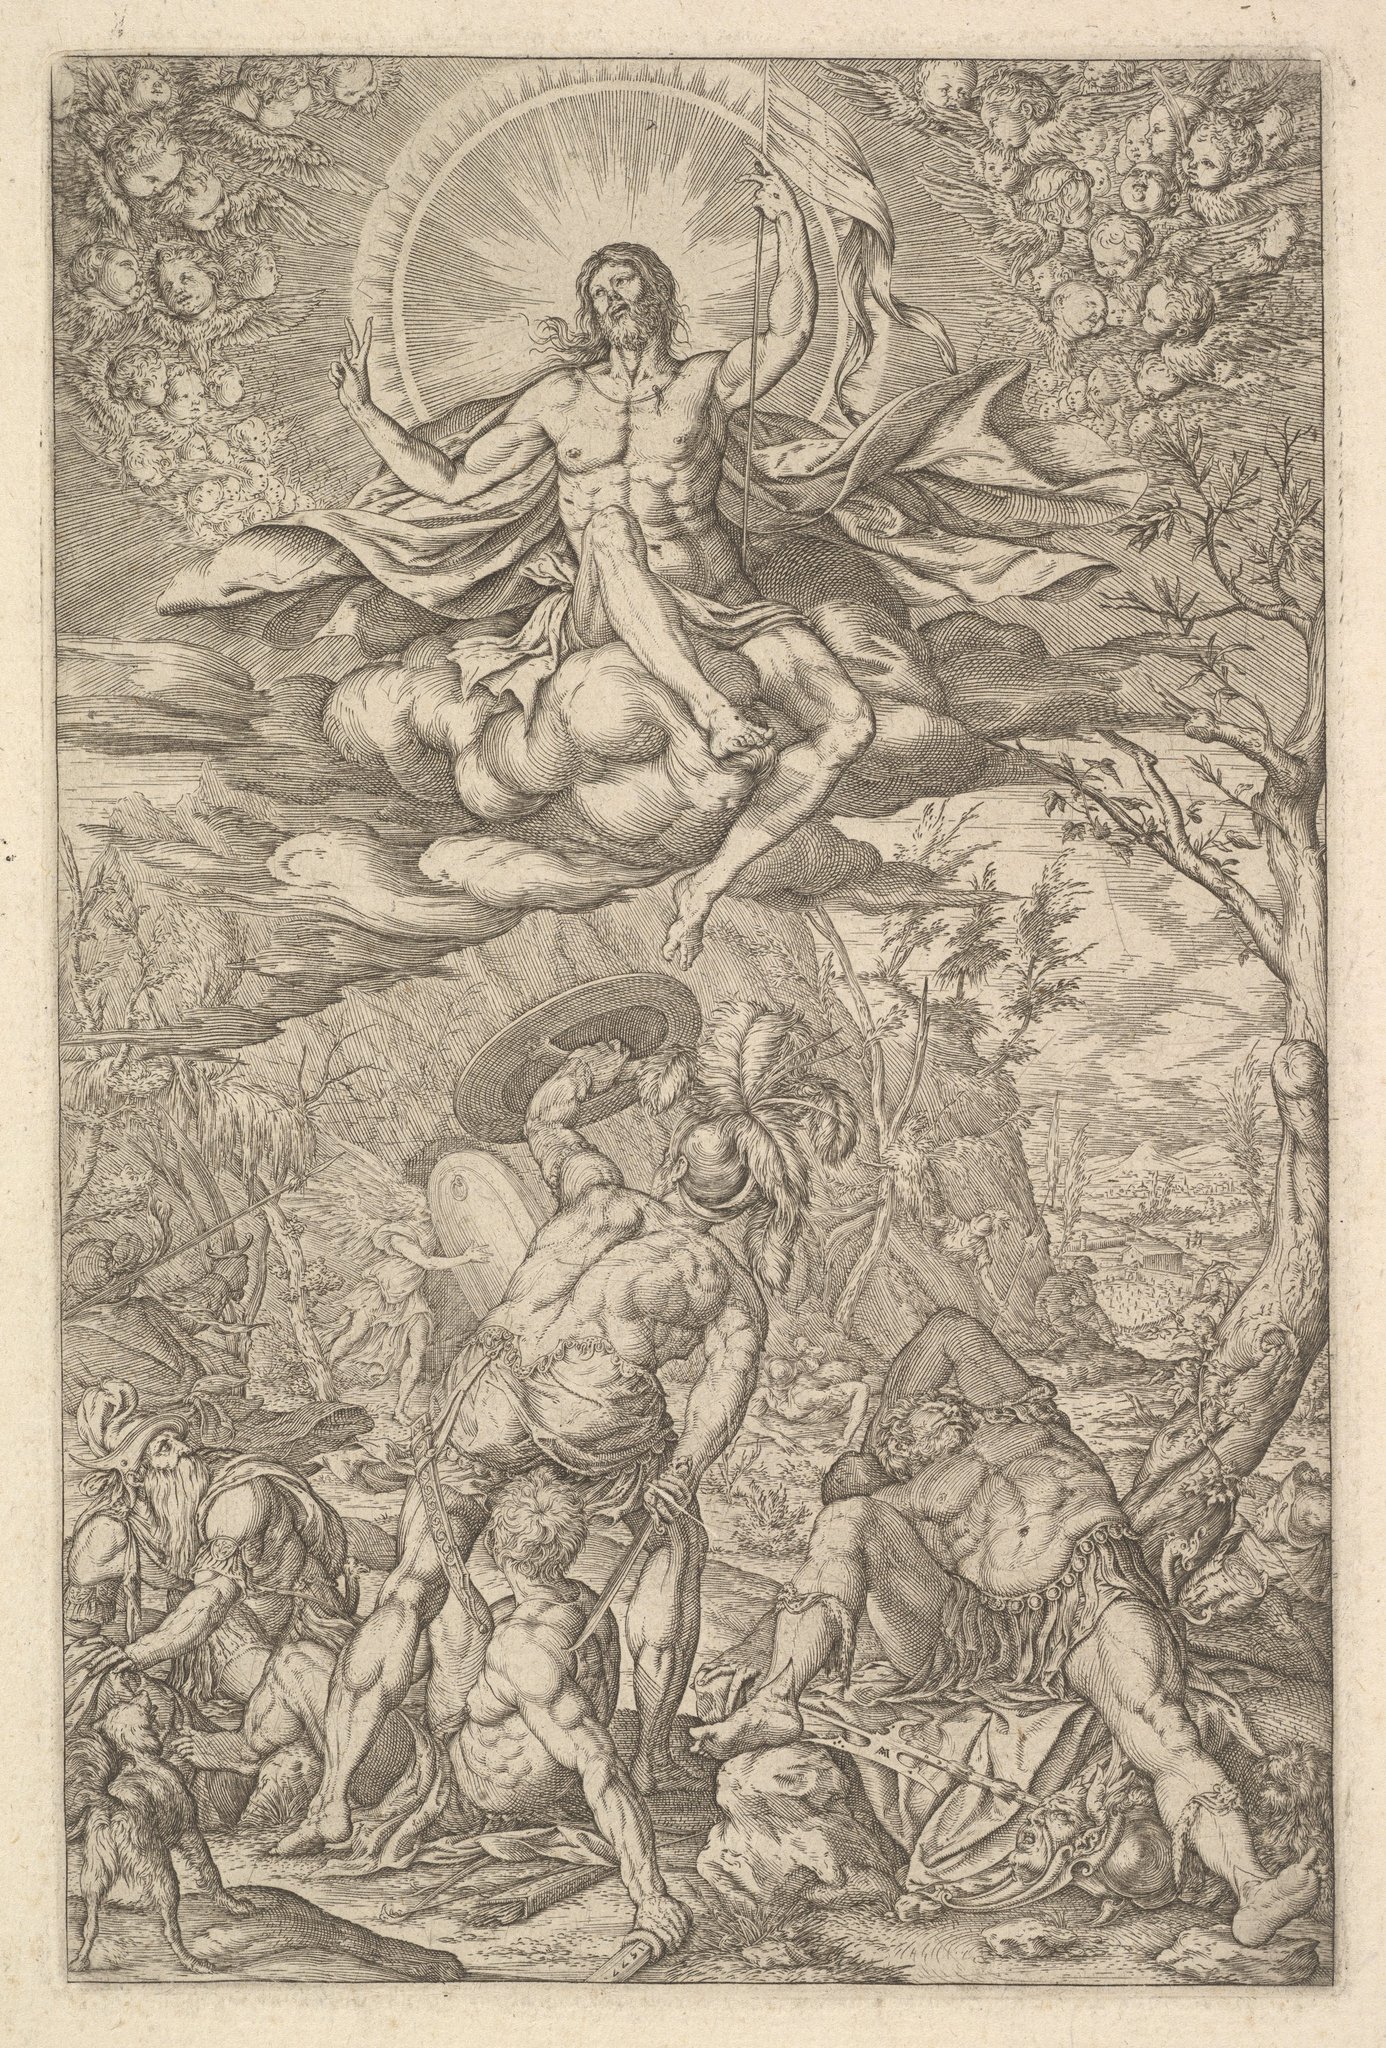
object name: print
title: Resurrection of Christ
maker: melchior meier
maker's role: artist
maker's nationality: german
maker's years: 1572-1582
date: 1577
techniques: etching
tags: soldiers,sleeping,putti,christ